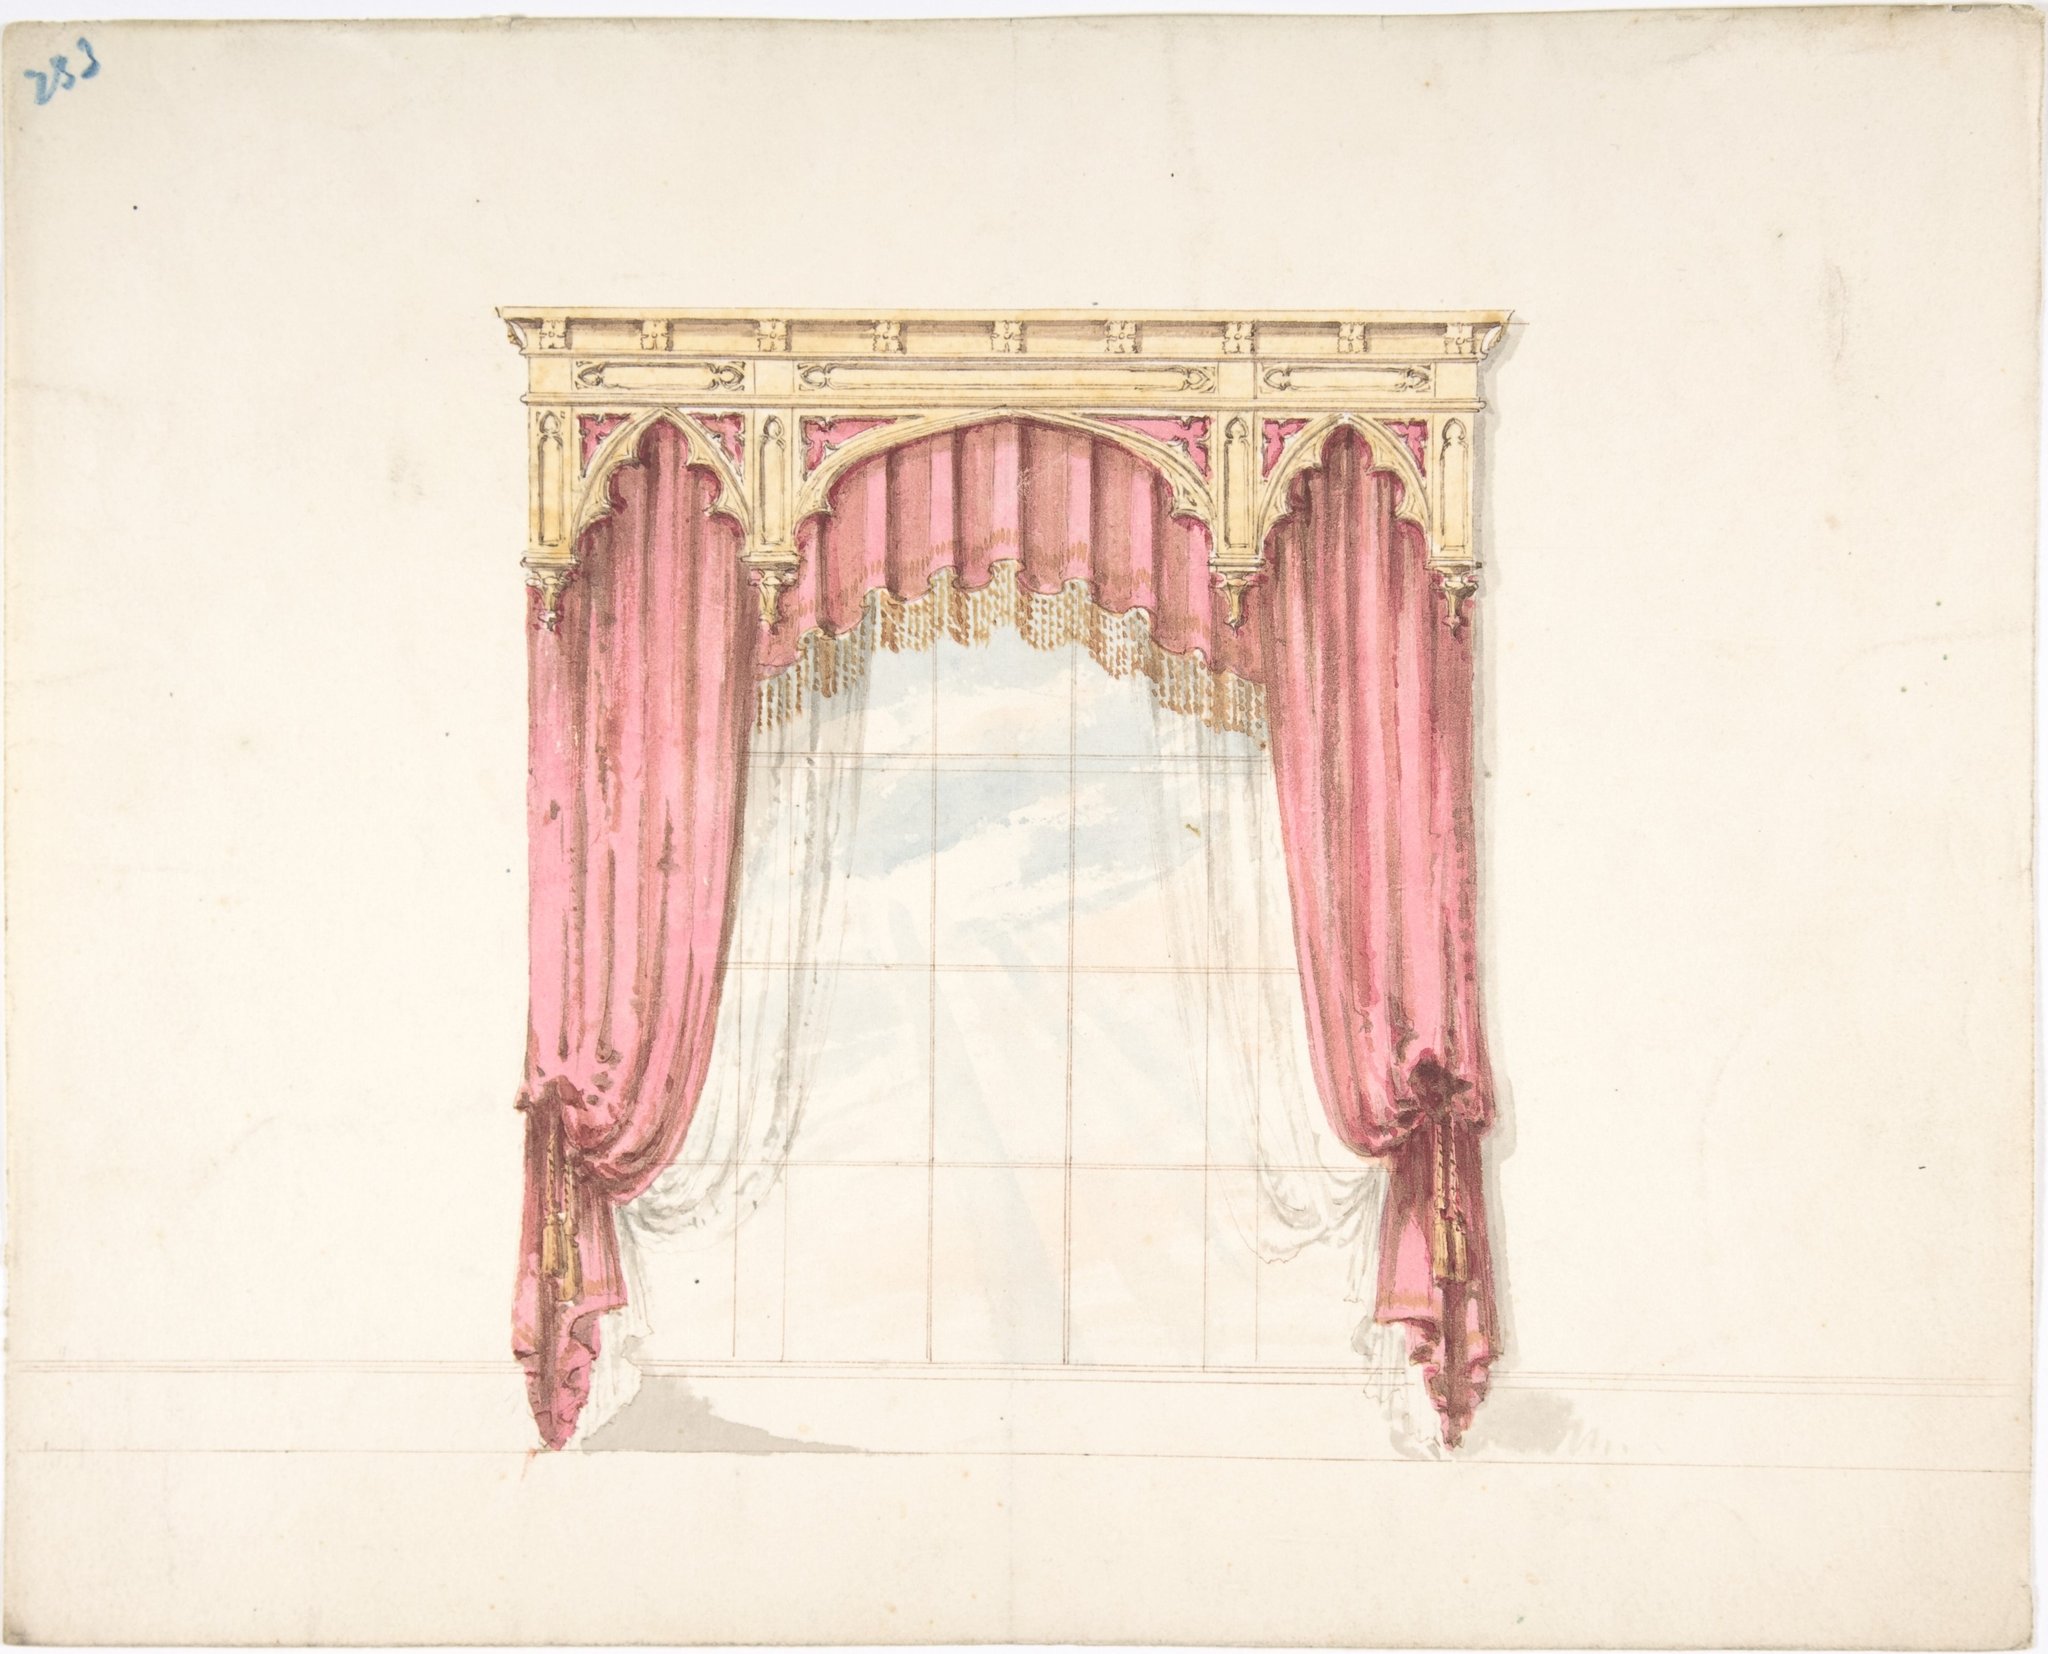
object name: drawing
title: Design for Red Curtains with Gold Fringes and a Gold Gothic Pediment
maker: anonymous, british, 19th century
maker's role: artist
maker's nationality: british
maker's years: 1800-1900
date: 1801-1833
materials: ink, watercolor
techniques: brush, pen, wash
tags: curtains